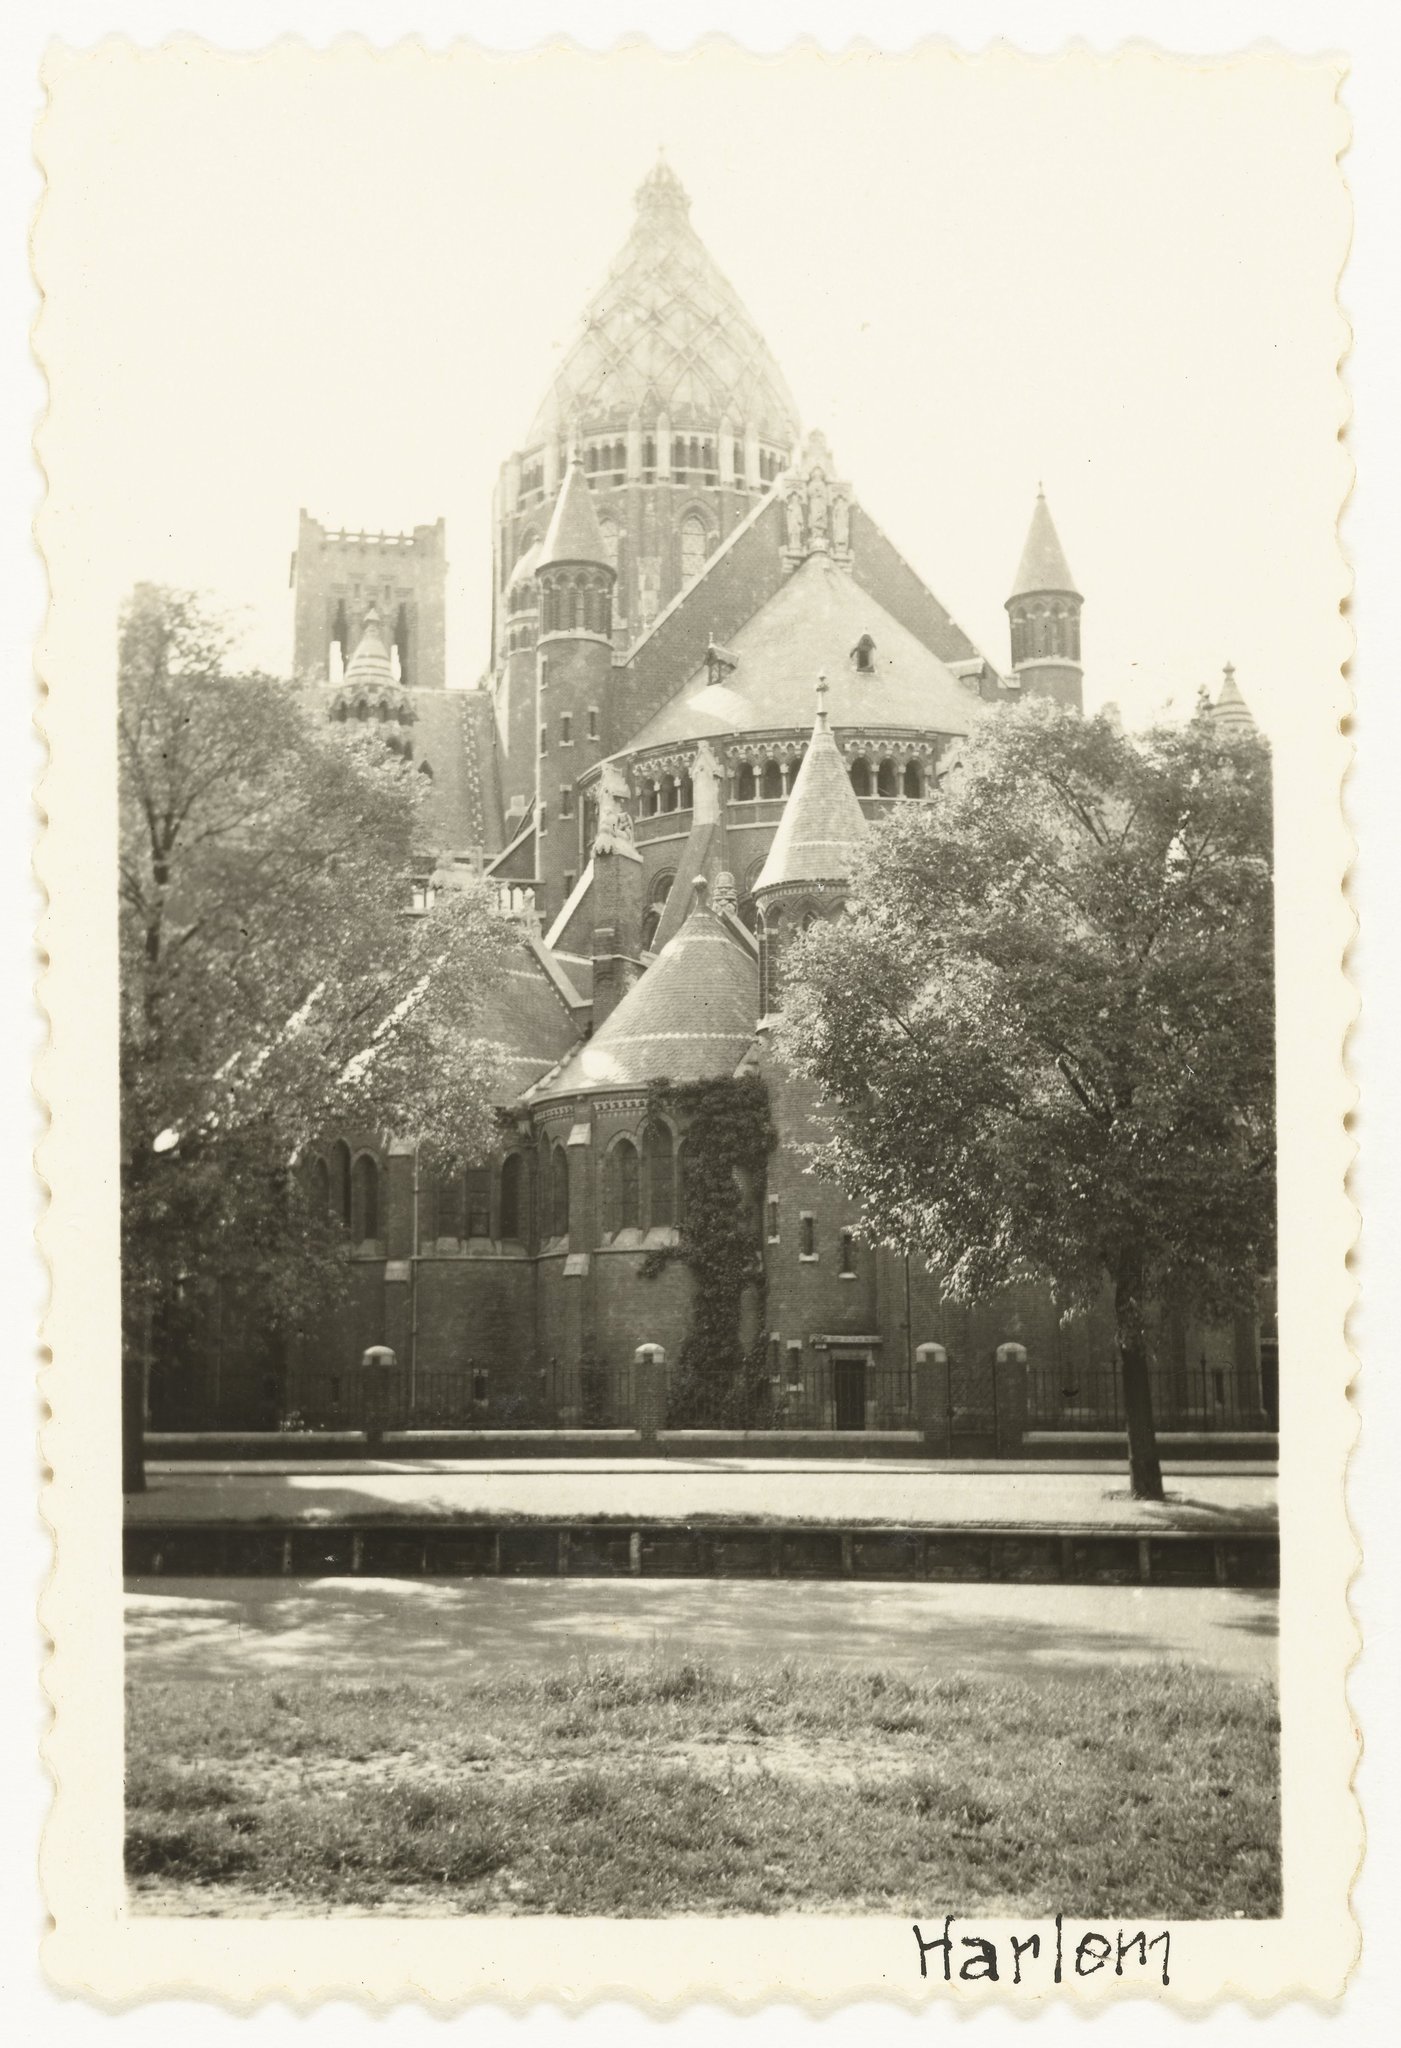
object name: photograph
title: Kathedrale Basiliek Sint Bavo in Haarlem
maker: Anonymous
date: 1940-1941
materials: photographic support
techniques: gelatin silver print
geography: haarlem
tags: church (exterior), occupation ~ war, haarlem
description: Kathedrale Basiliek Sint Bavo in Haarlem. Bomen staan in blad